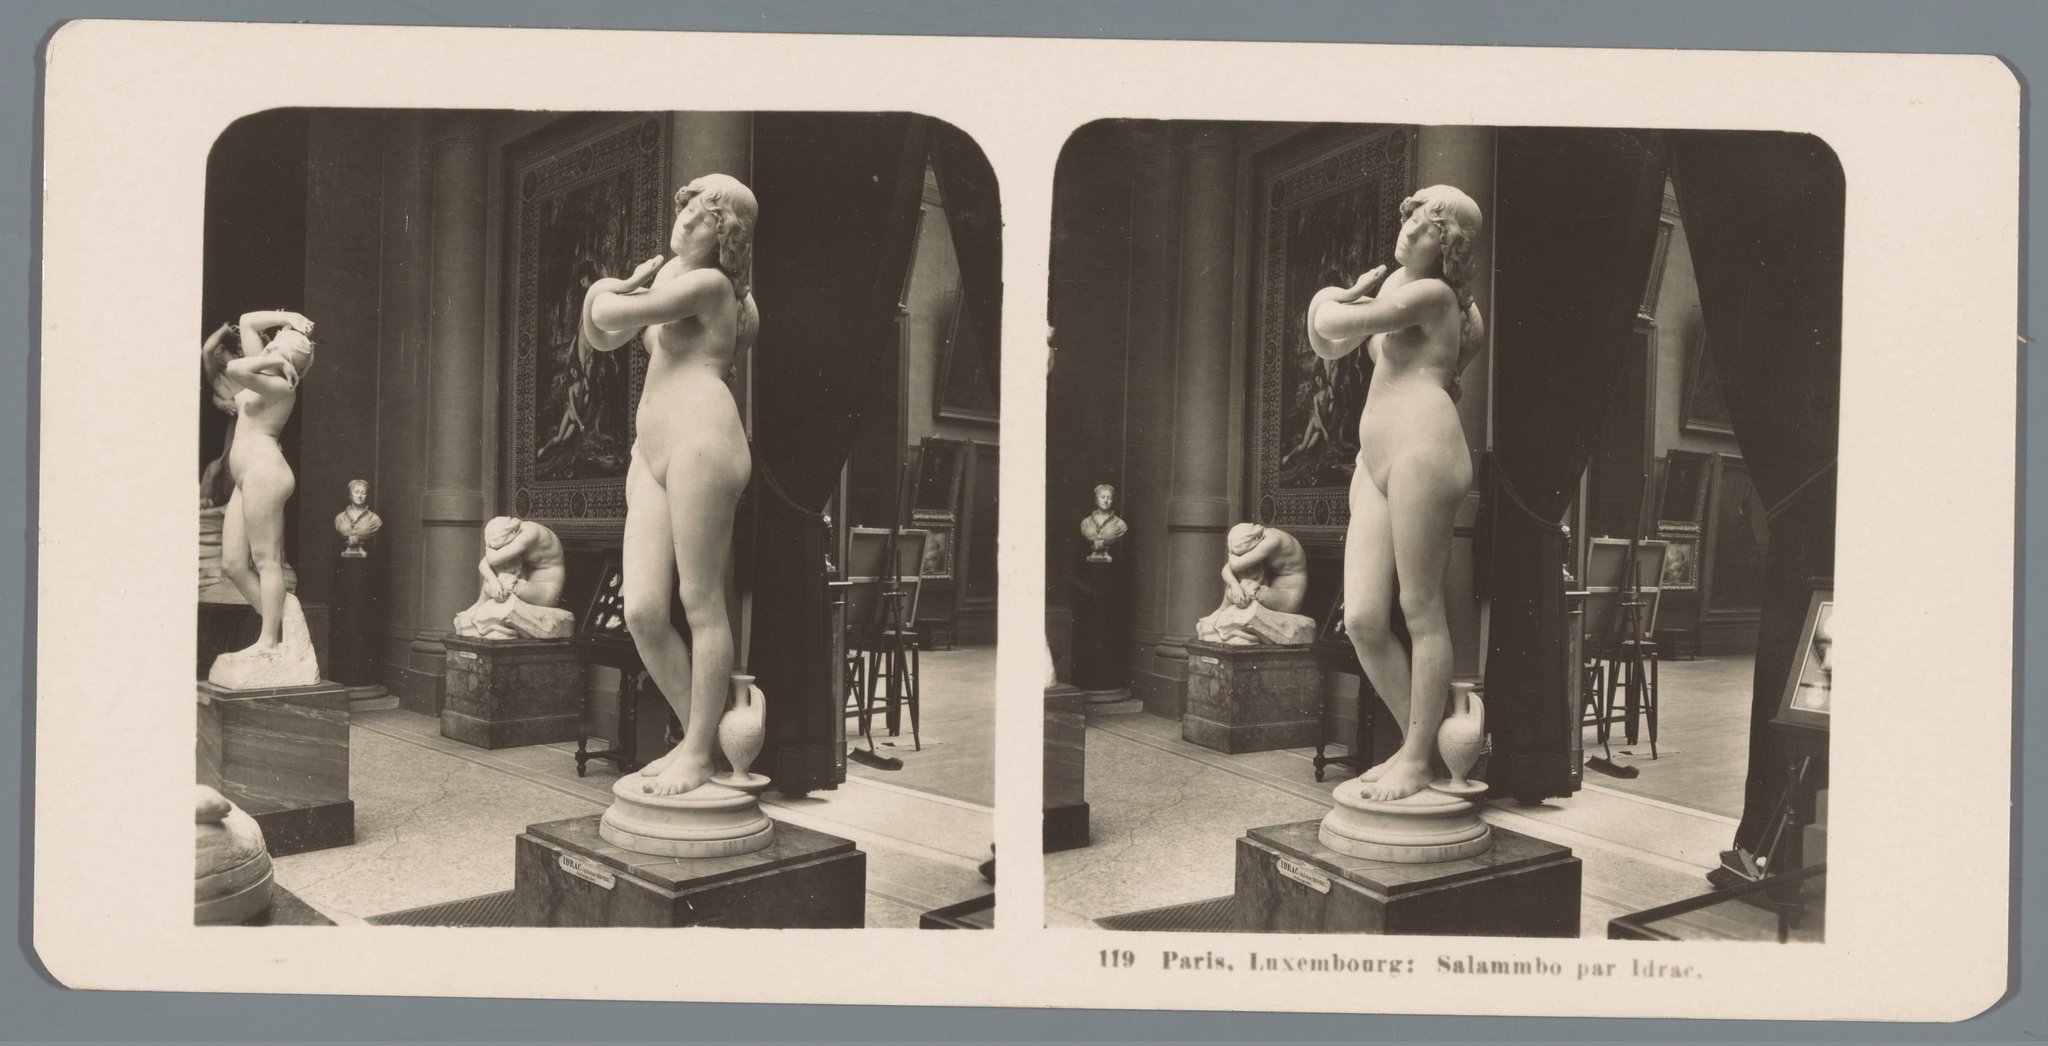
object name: stereograph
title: Paris, Luxembourg: Salammbo par Idrac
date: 1904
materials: cardboard, photographic support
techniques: gelatin silver print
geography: musée du luxembourg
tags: woman (showing herself) undressed, quasi-nude, permanent exhibition, museum, sculpture, female literary characters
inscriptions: inscription: ‘Neue Photographische Gesellschaft A.-G. Steglitz-Berlin 1904.’, number: ‘119’